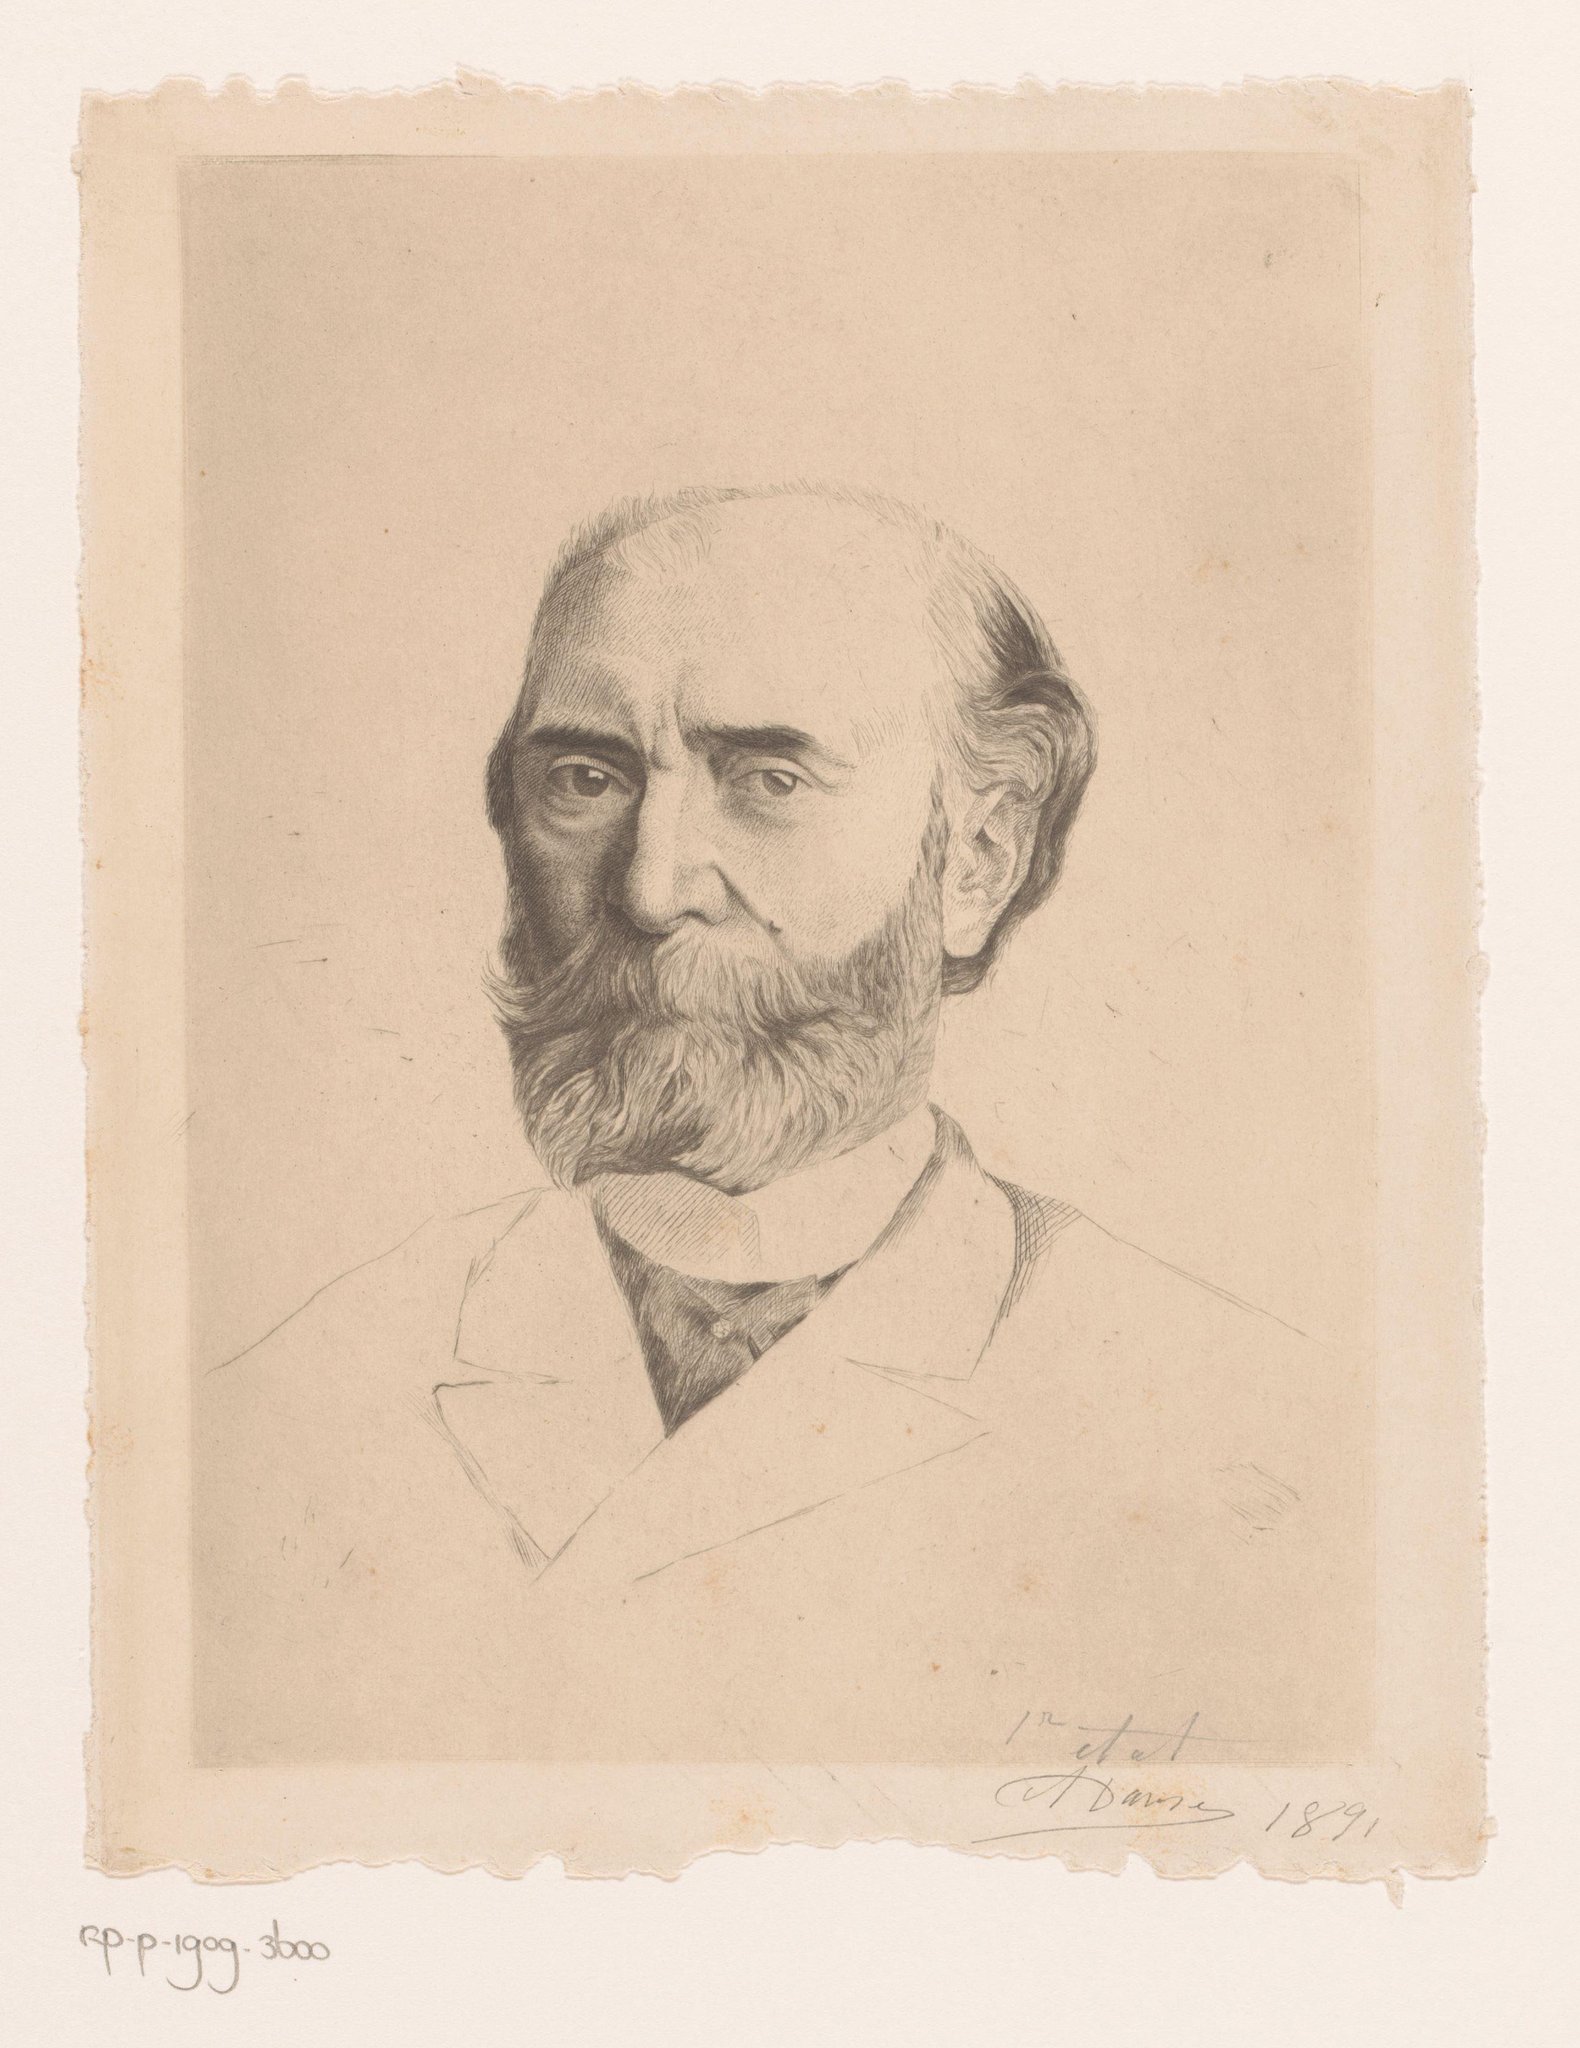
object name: print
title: Portret van Jean Baptiste Michiels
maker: auguste danse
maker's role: print maker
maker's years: 1829-1929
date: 1891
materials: paper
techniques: etching, intaglio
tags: antwerp, jean baptiste pierre michiels, engraver, etcher, portrait, self-portrait of graphic artist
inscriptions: annotation: ‘1er etat’, collector's mark: Lugt 2228